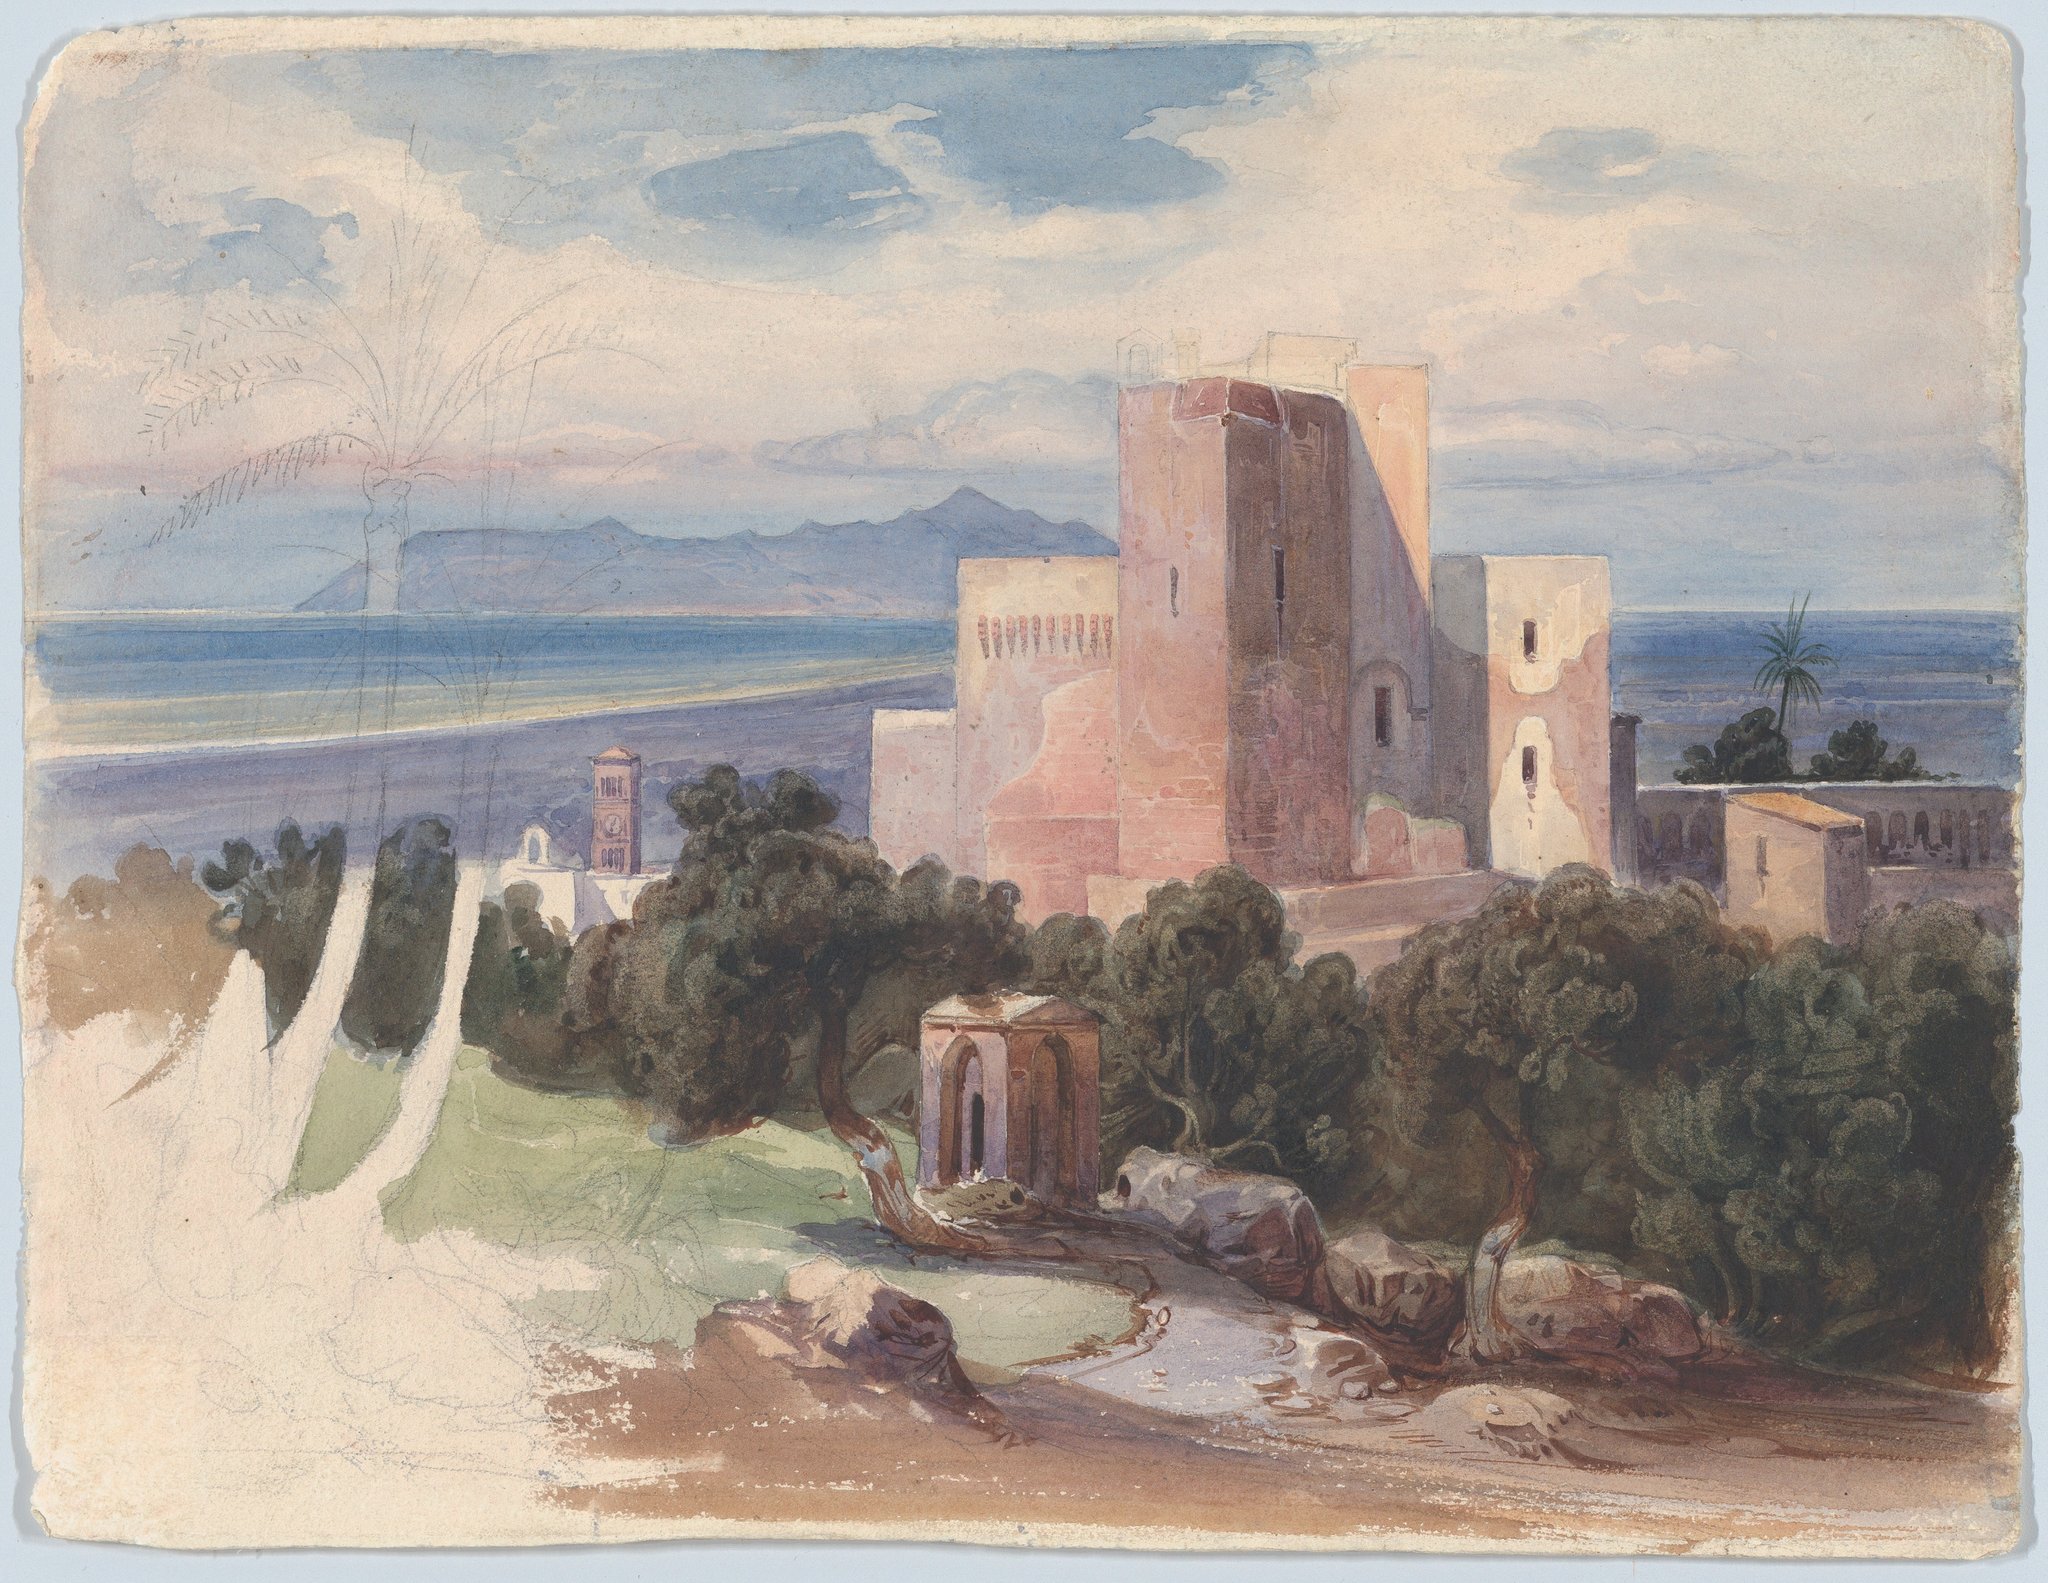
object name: drawing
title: View on Terracina with Mount Circeo (recto); View of the Roman Campagna with an Aquaduct (verso)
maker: carl von blaas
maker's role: artist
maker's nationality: austrian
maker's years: 1815-1894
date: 1834-1866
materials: graphite, watercolor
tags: buildings,landscapes,aqueducts